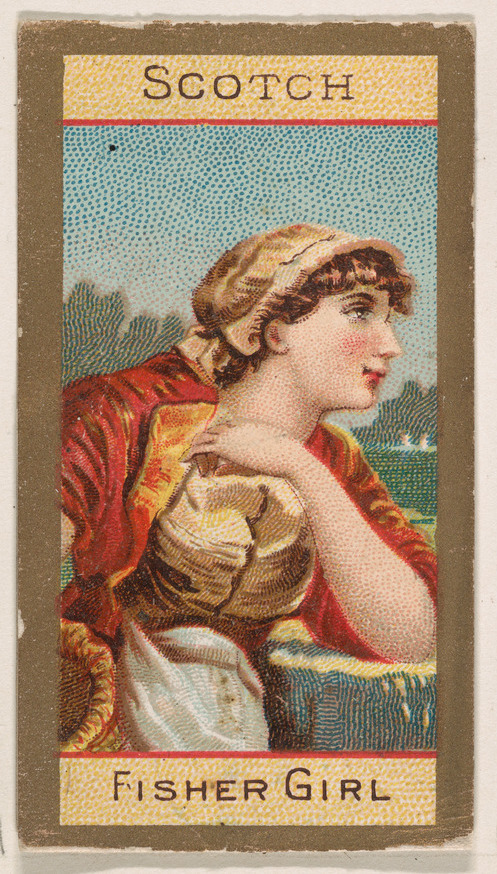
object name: print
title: Scotch, Fisher Girl, from Types of Nationalities (N240) issued by Kinney Bros.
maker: kinney brothers tobacco company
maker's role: publisher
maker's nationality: american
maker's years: 1869-2011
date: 1890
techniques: color lithograph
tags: girls,profiles